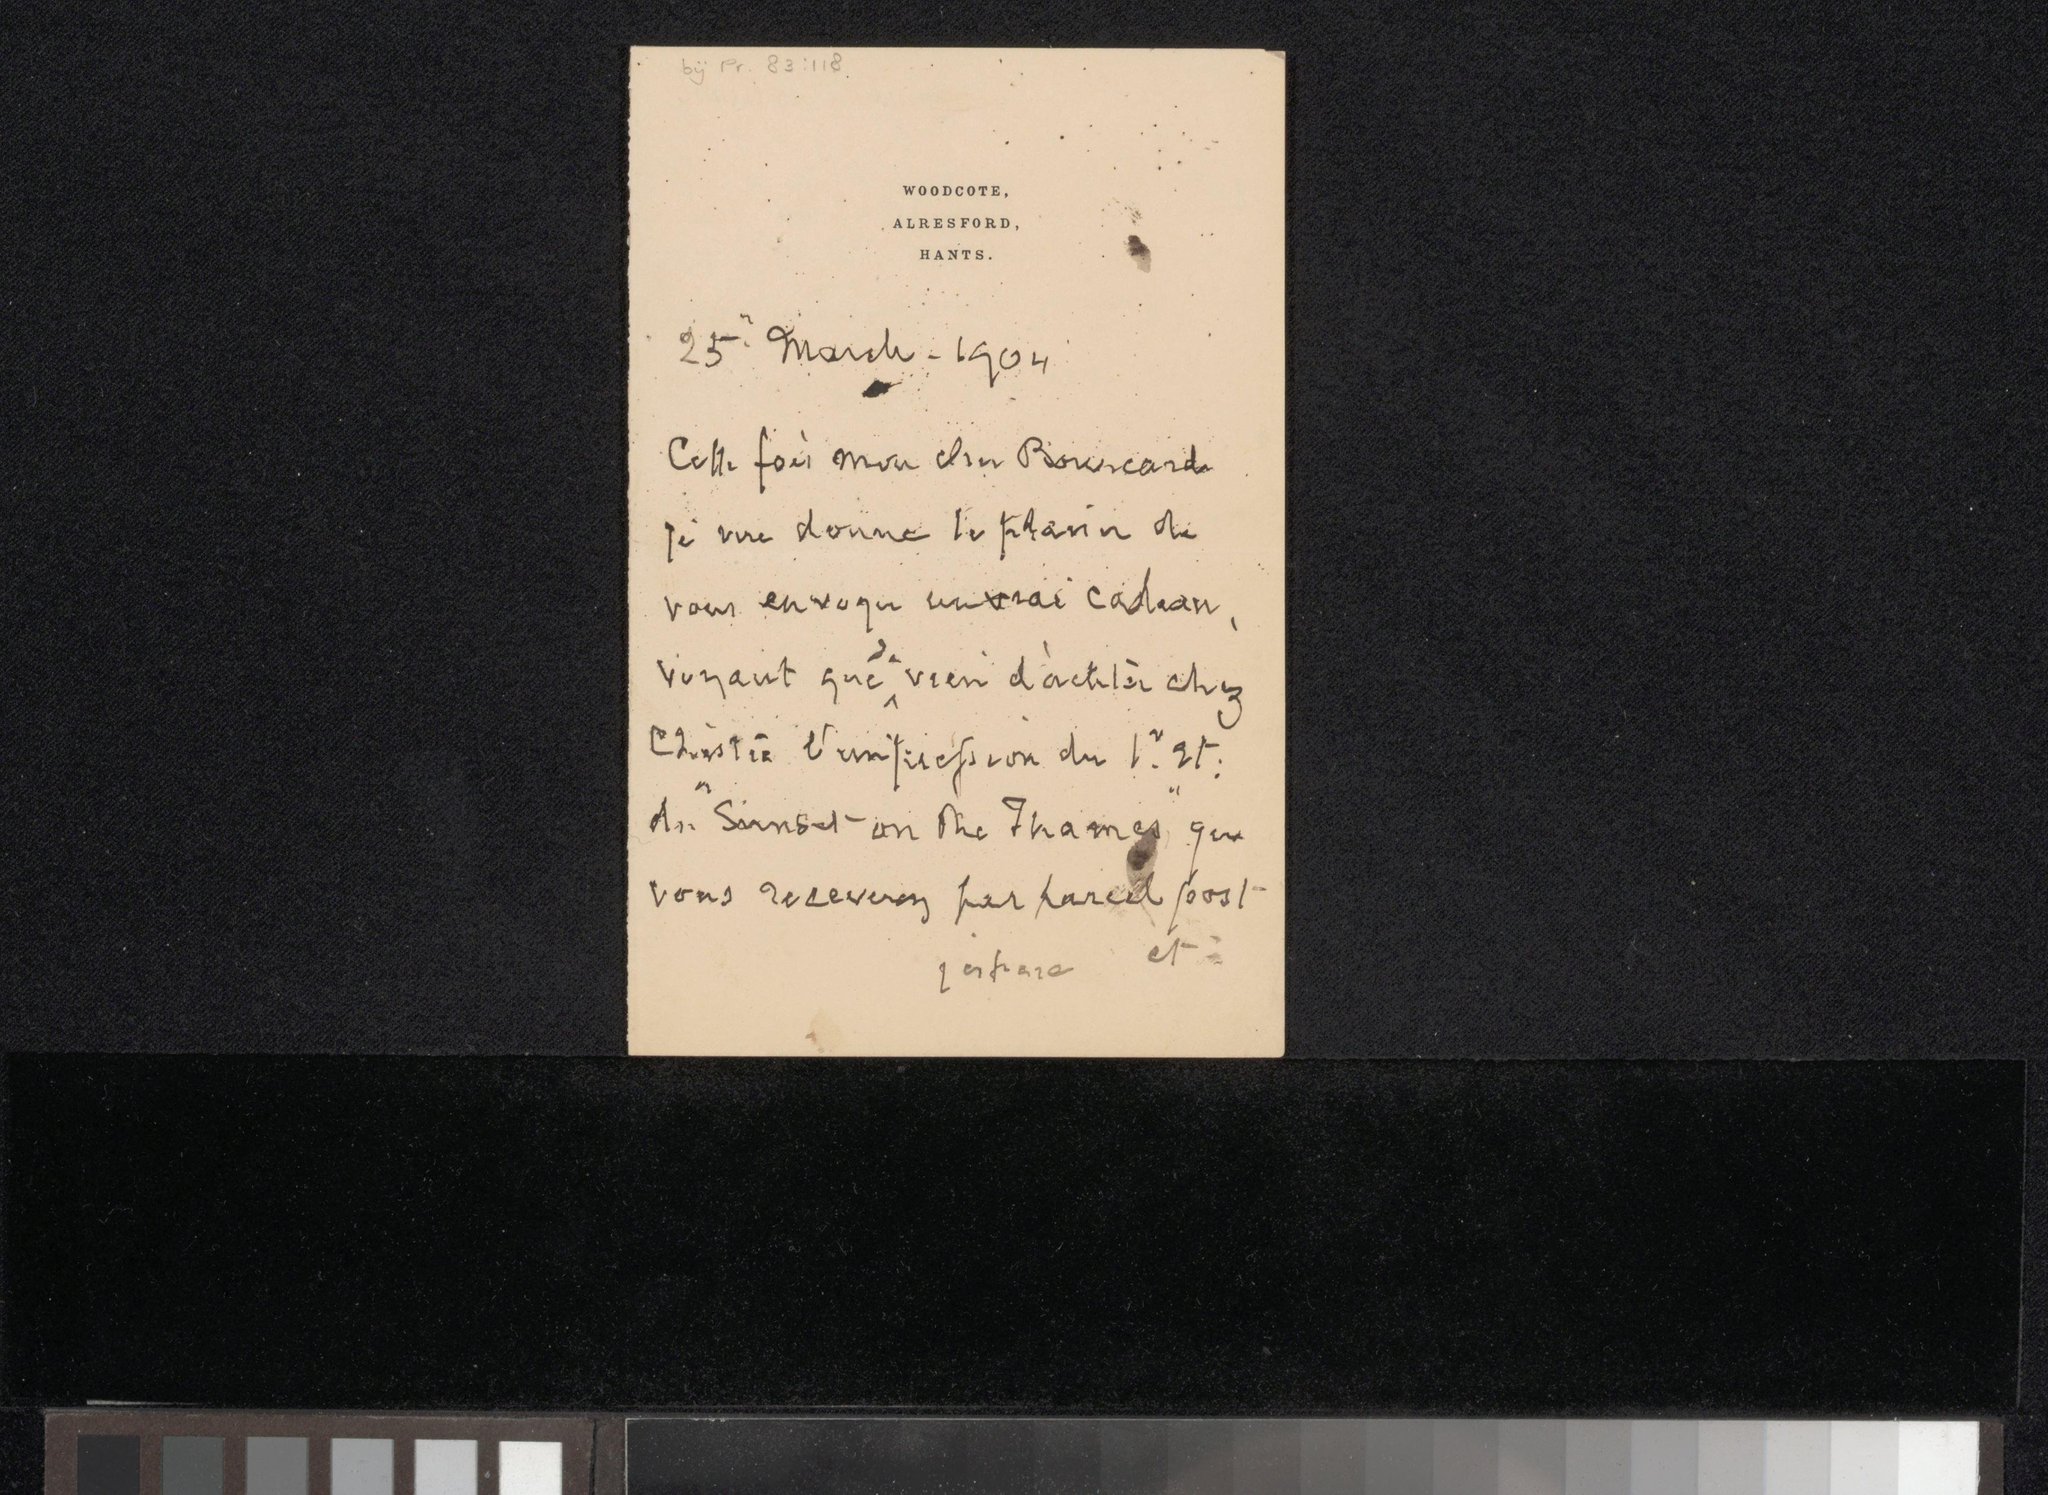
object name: letter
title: Brief aan Gustave Bourcard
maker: francis seymour-haden (sir)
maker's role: print maker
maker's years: 1818-1910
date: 1904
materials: ink, paper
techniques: pen, printing, writing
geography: woodcote manor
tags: gustave bourcard, the graphic arts, london